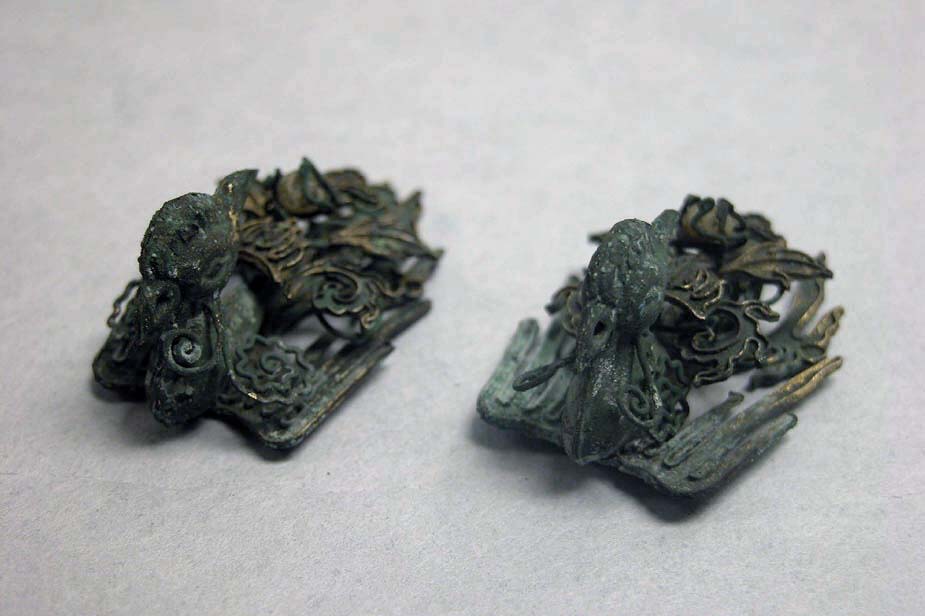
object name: hair ornament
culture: chinese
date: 960-1279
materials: silver gilt